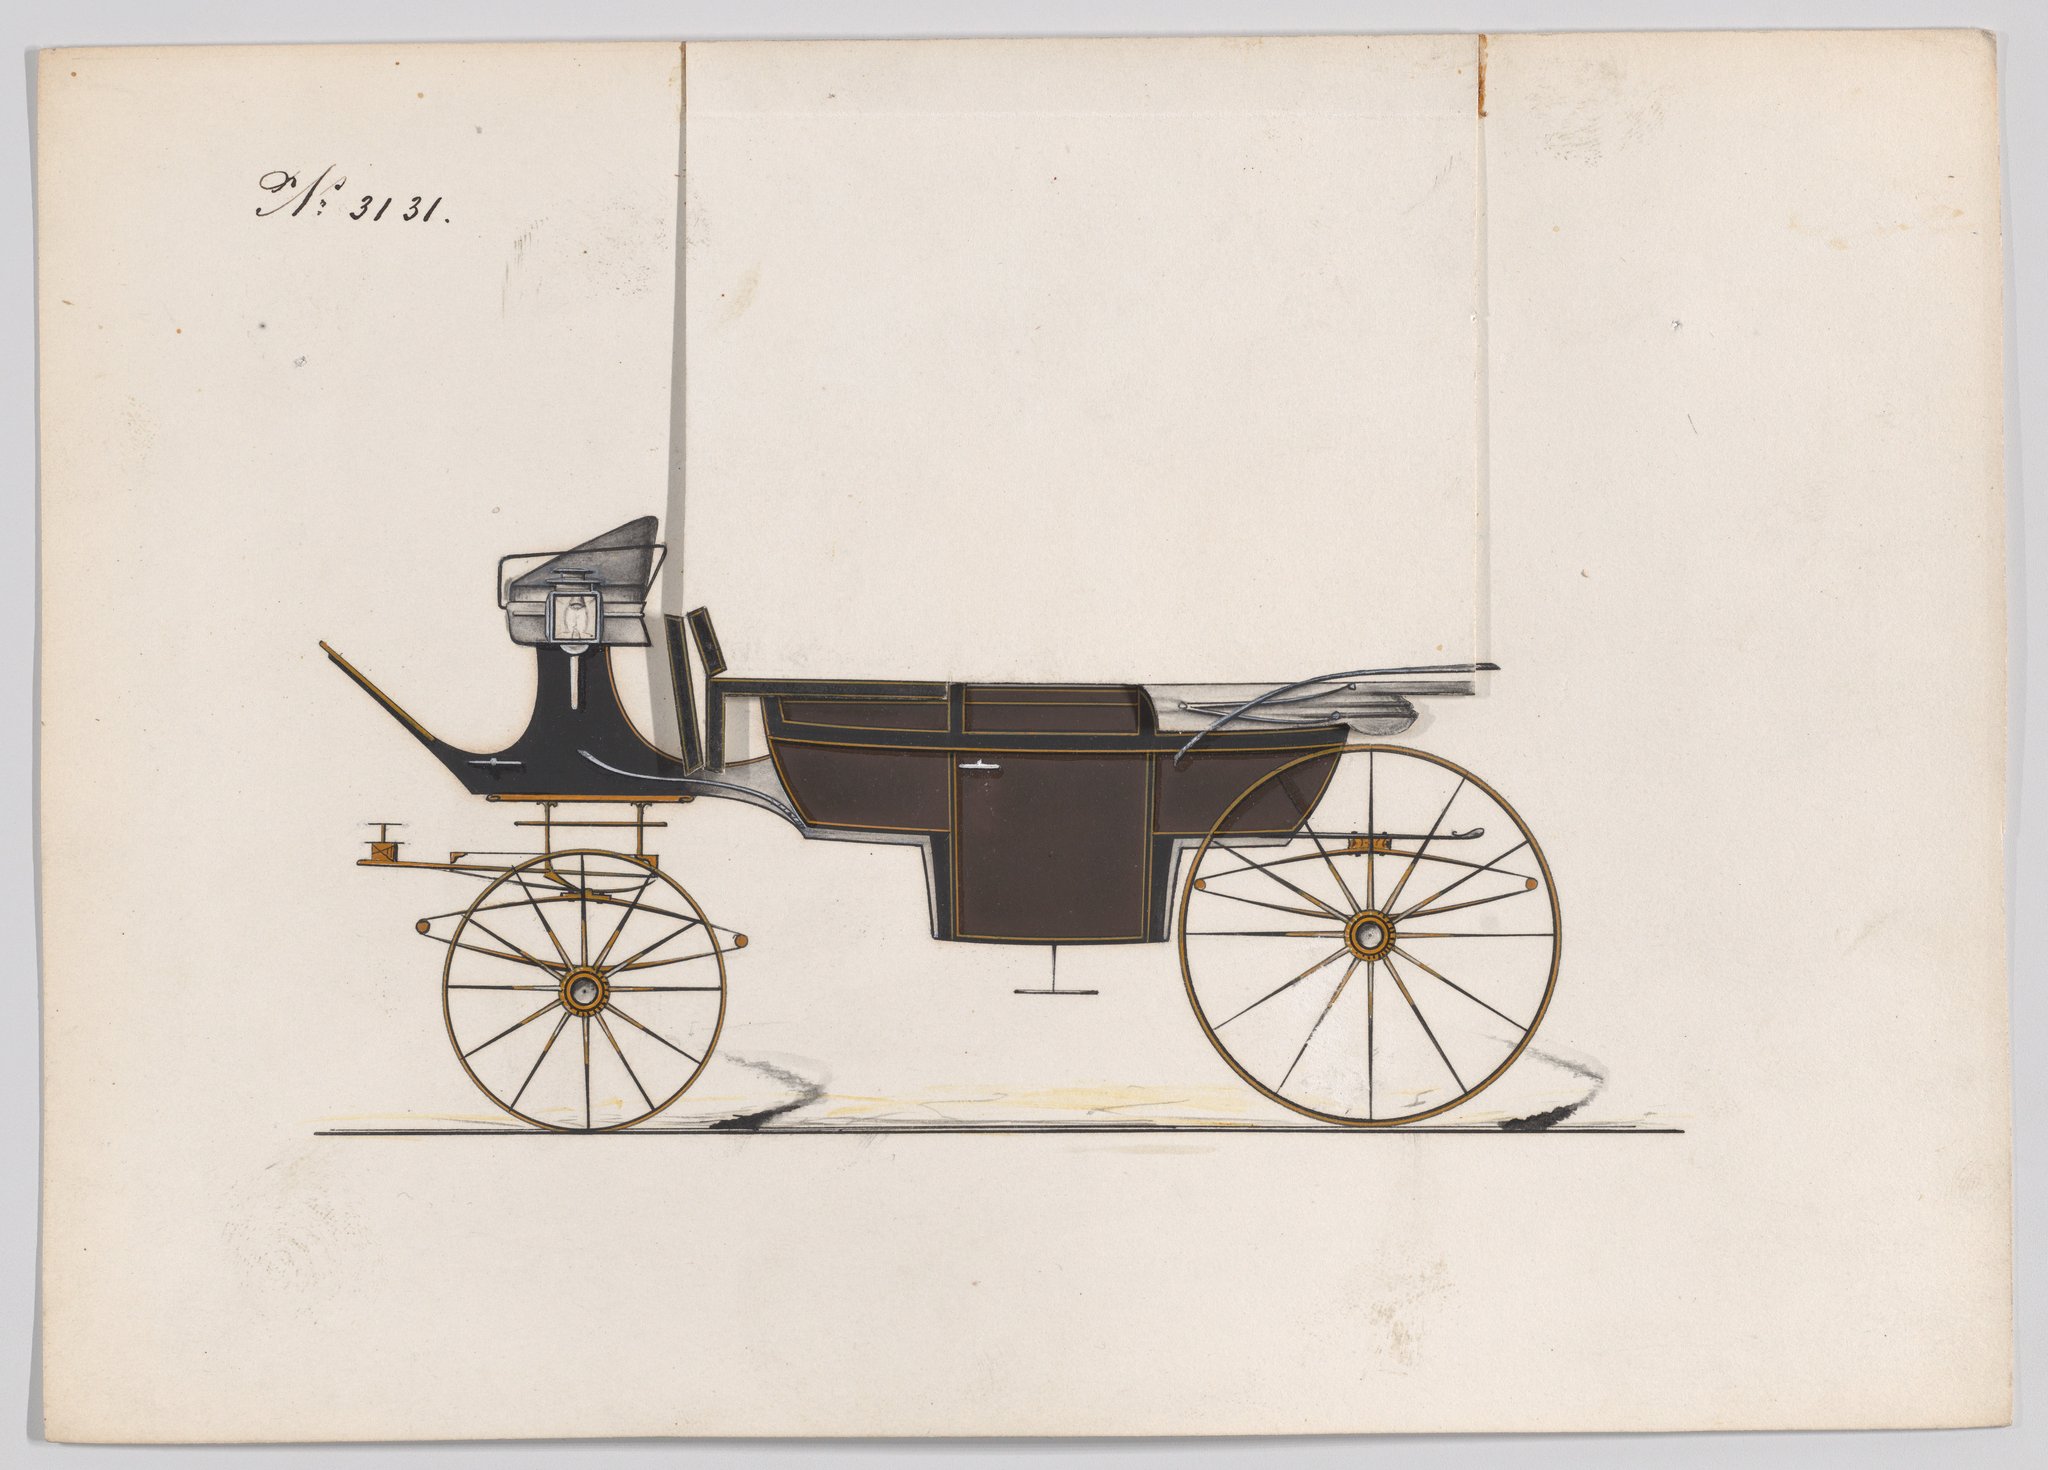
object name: drawing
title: Design for Landau, No. 3131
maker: brewster & co.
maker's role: manufacturer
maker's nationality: american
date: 1875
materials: gouache, gum arabic, ink, watercolor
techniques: pen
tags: carriages